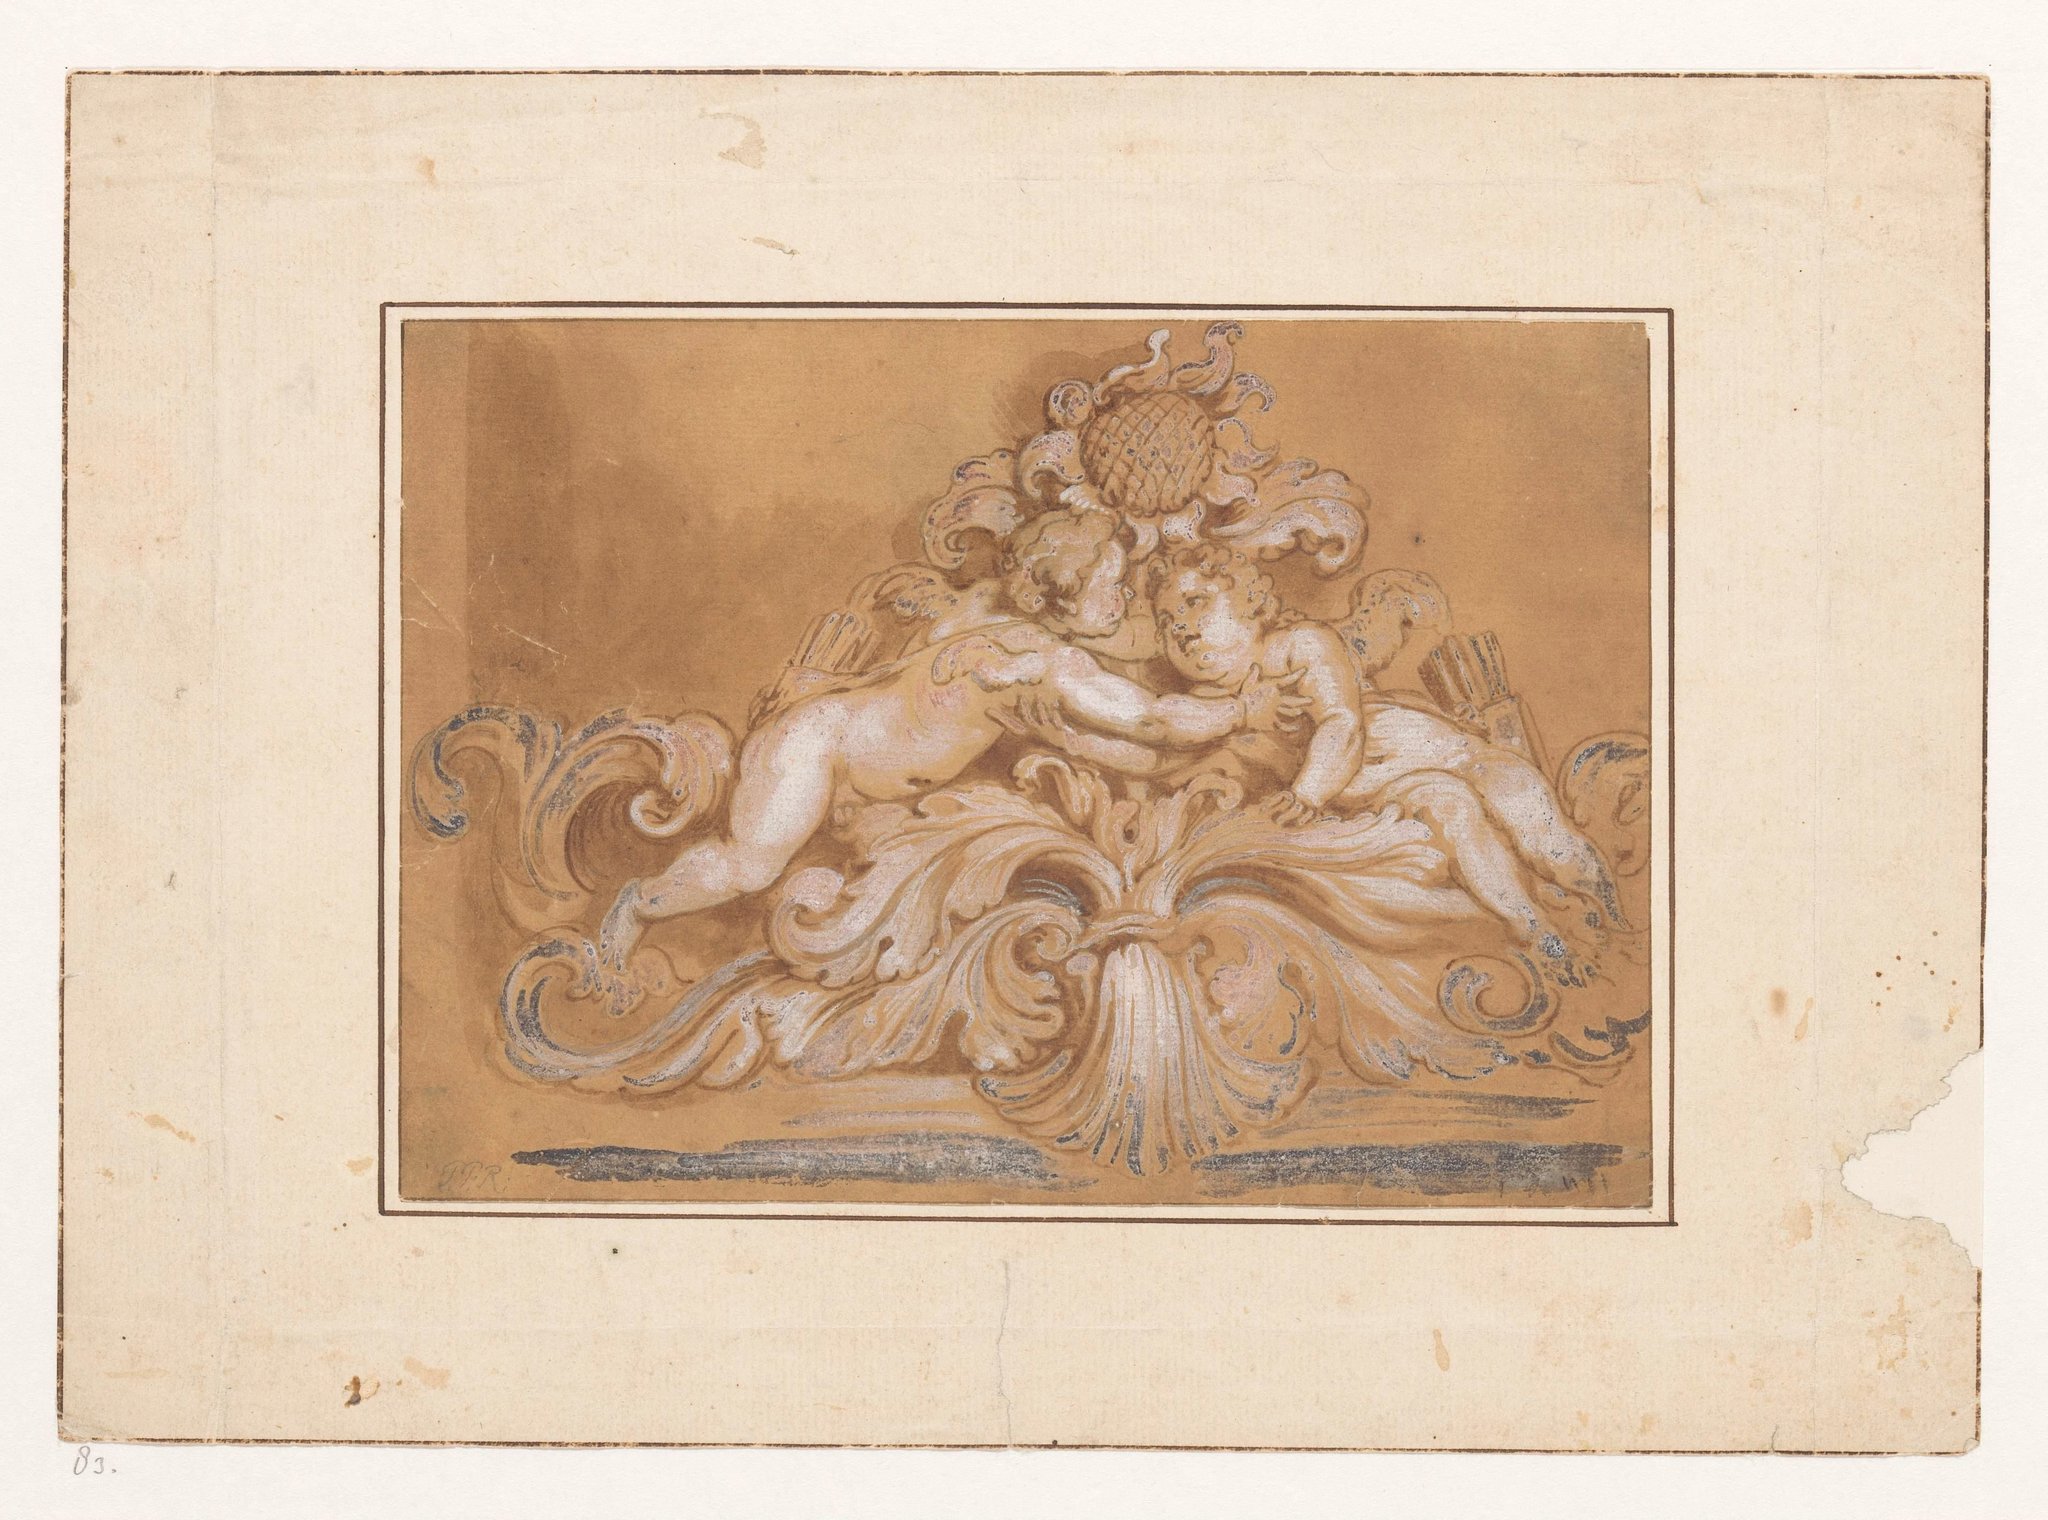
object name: drawing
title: Ornament met twee putti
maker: Anonymous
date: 1650-1750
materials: paint, ink, paper, watercolor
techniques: brush, pen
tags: bodegraven, draughtsman, jan brandes, cupids: 'amores', 'amoretti', 'putti'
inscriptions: signature (possibly false): ‘P.P.R.’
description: Sculptuur met twee engeltjes en bladranken.